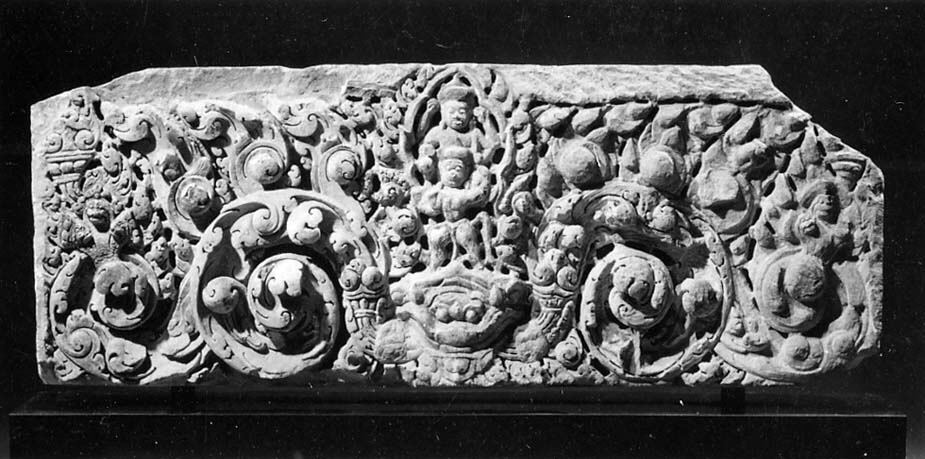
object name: lintel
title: Lintel with Vishnu on Garuda Standing on a Kala Head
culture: cambodian or thai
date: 1051-1100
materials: stone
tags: vishnu,hinduism